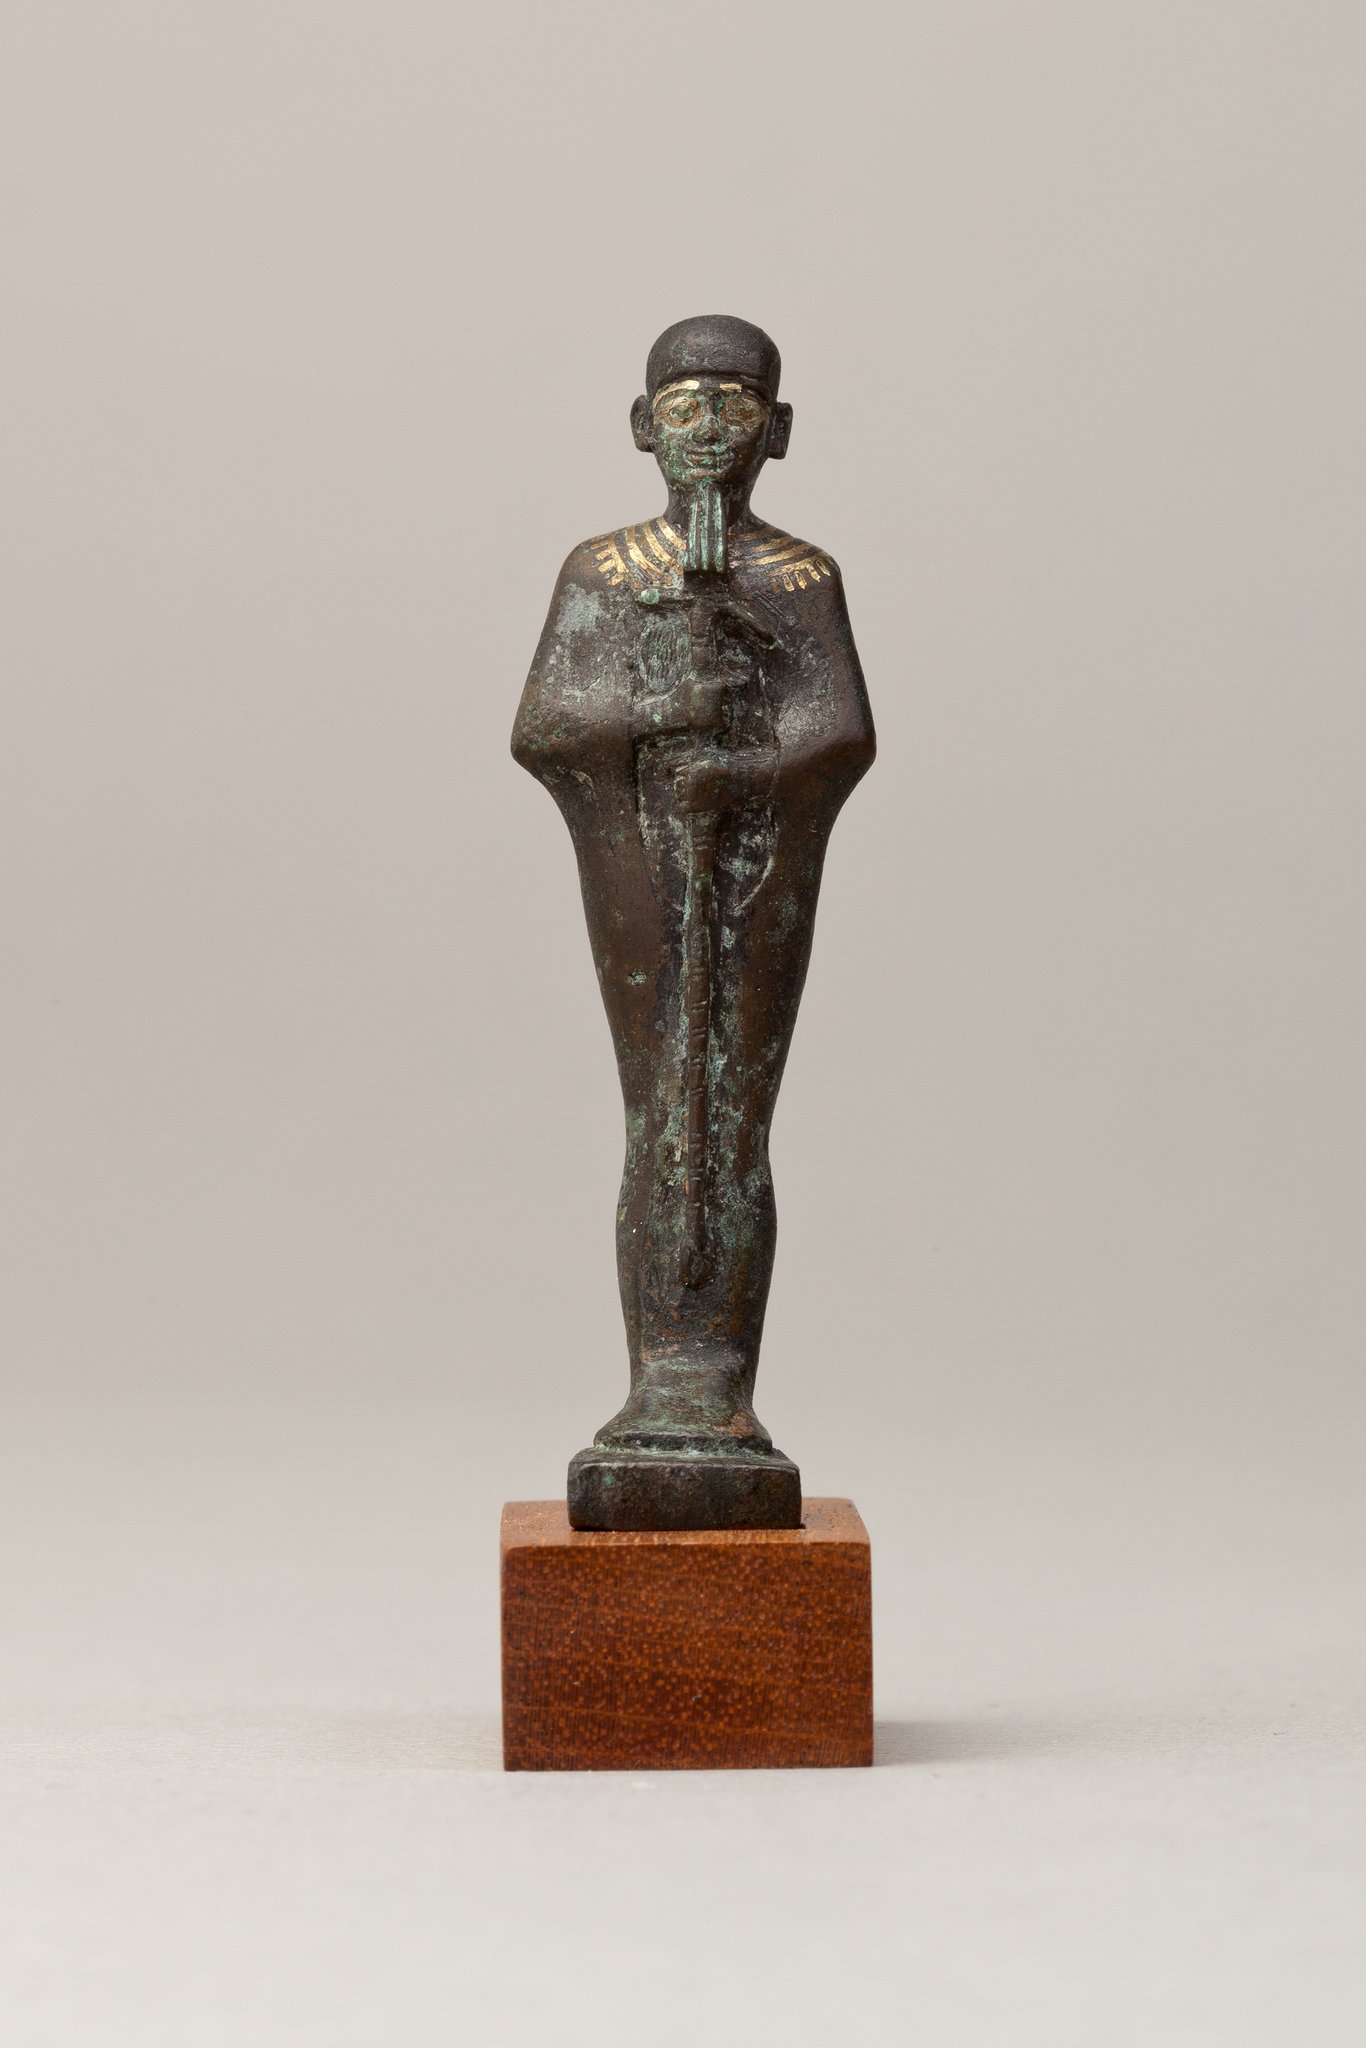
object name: ptah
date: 664-630 BCE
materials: metal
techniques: inlay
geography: egypt